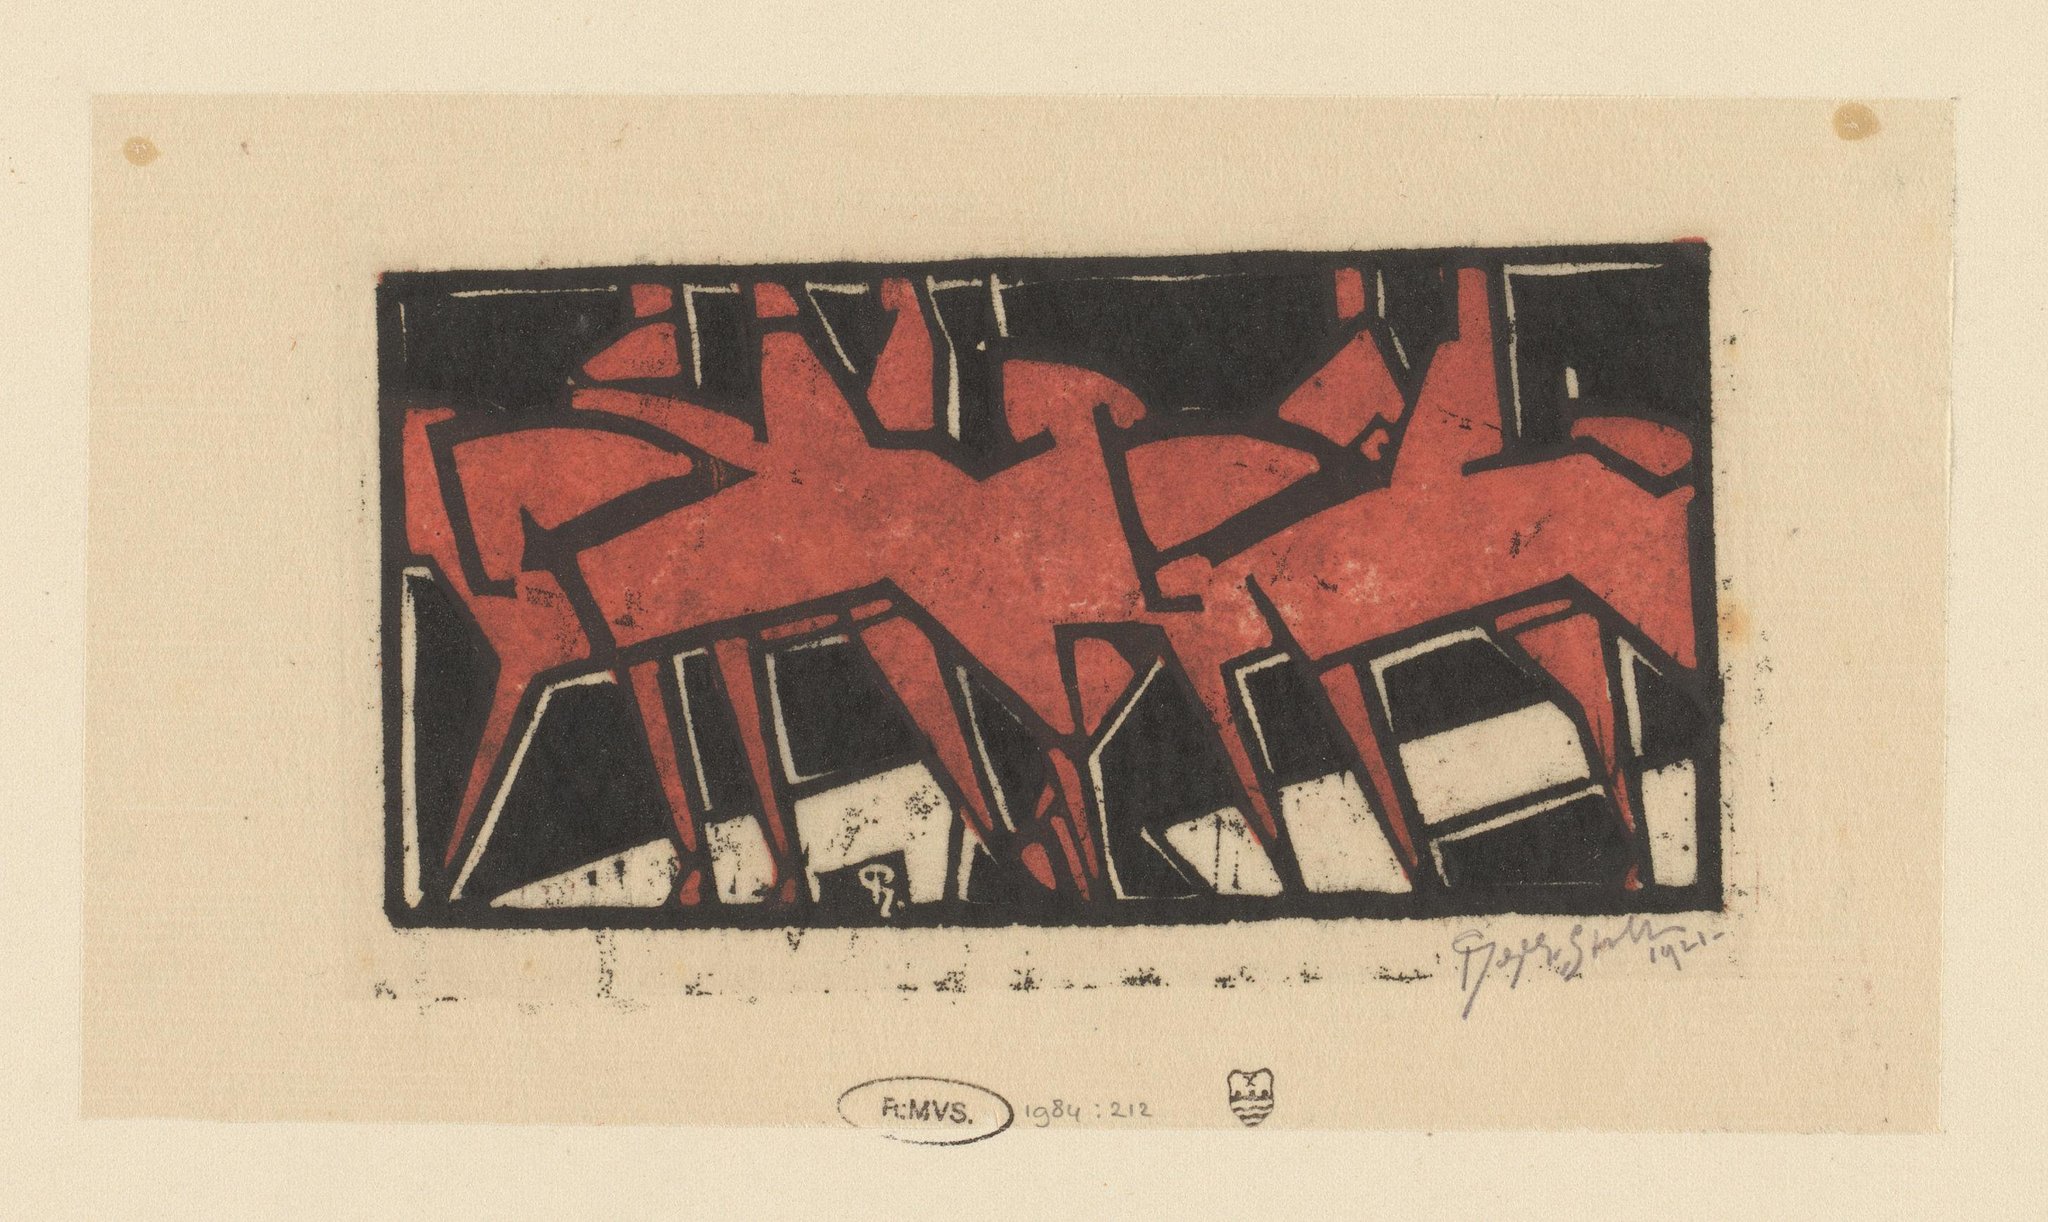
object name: print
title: Het paard, 6 studies in hout gesneden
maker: reijer stolk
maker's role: draughtsman, print maker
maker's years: 1896-1945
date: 1921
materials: paper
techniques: woodcut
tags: hitching up, harnessing ~ animal traction, horse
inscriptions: collector's mark: Lugt 2228, collector's mark: Lugt 2760